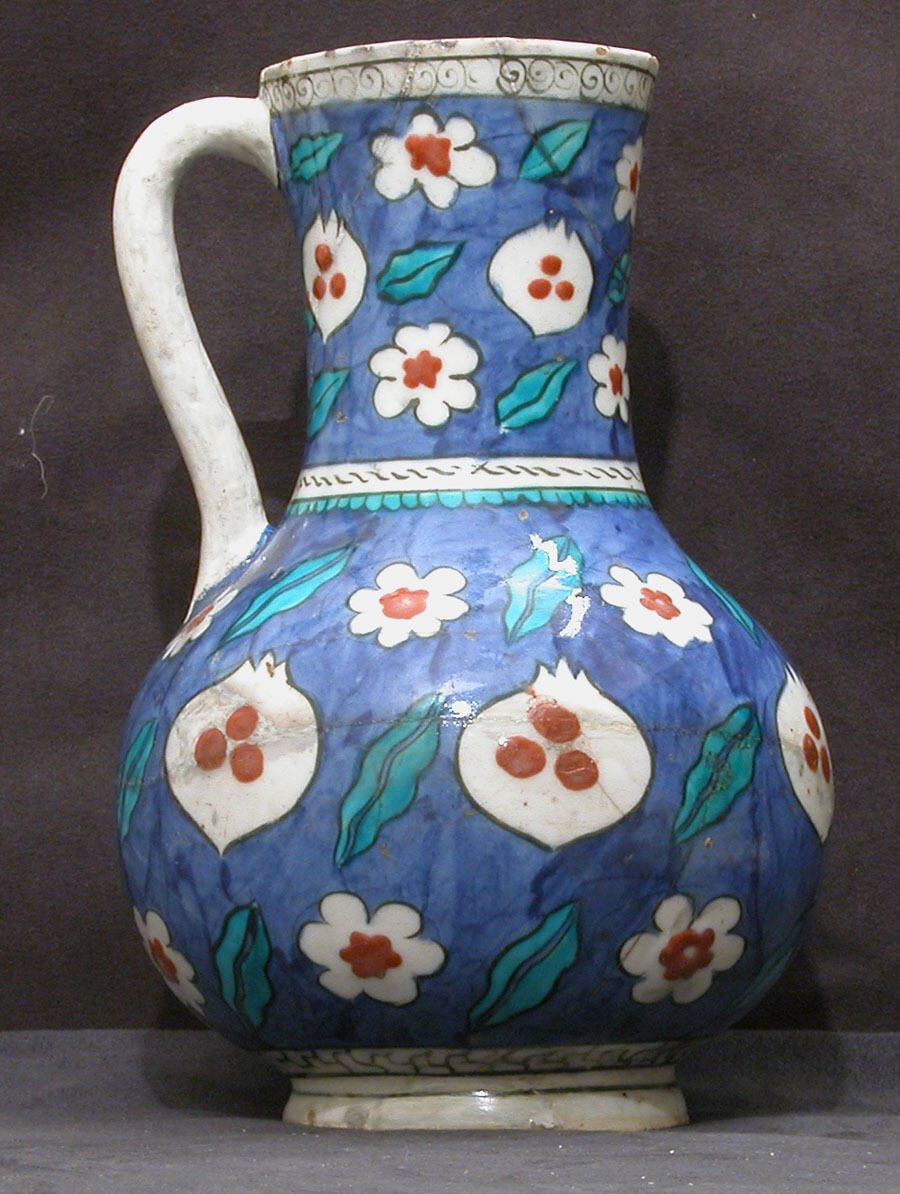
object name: ewer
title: Blue-ground Ewer with Floral, Tiger-stripe and 'Cintamani' Designs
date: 1580-1585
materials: earthenware, glaze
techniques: painting, polychrome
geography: turkey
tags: flowers